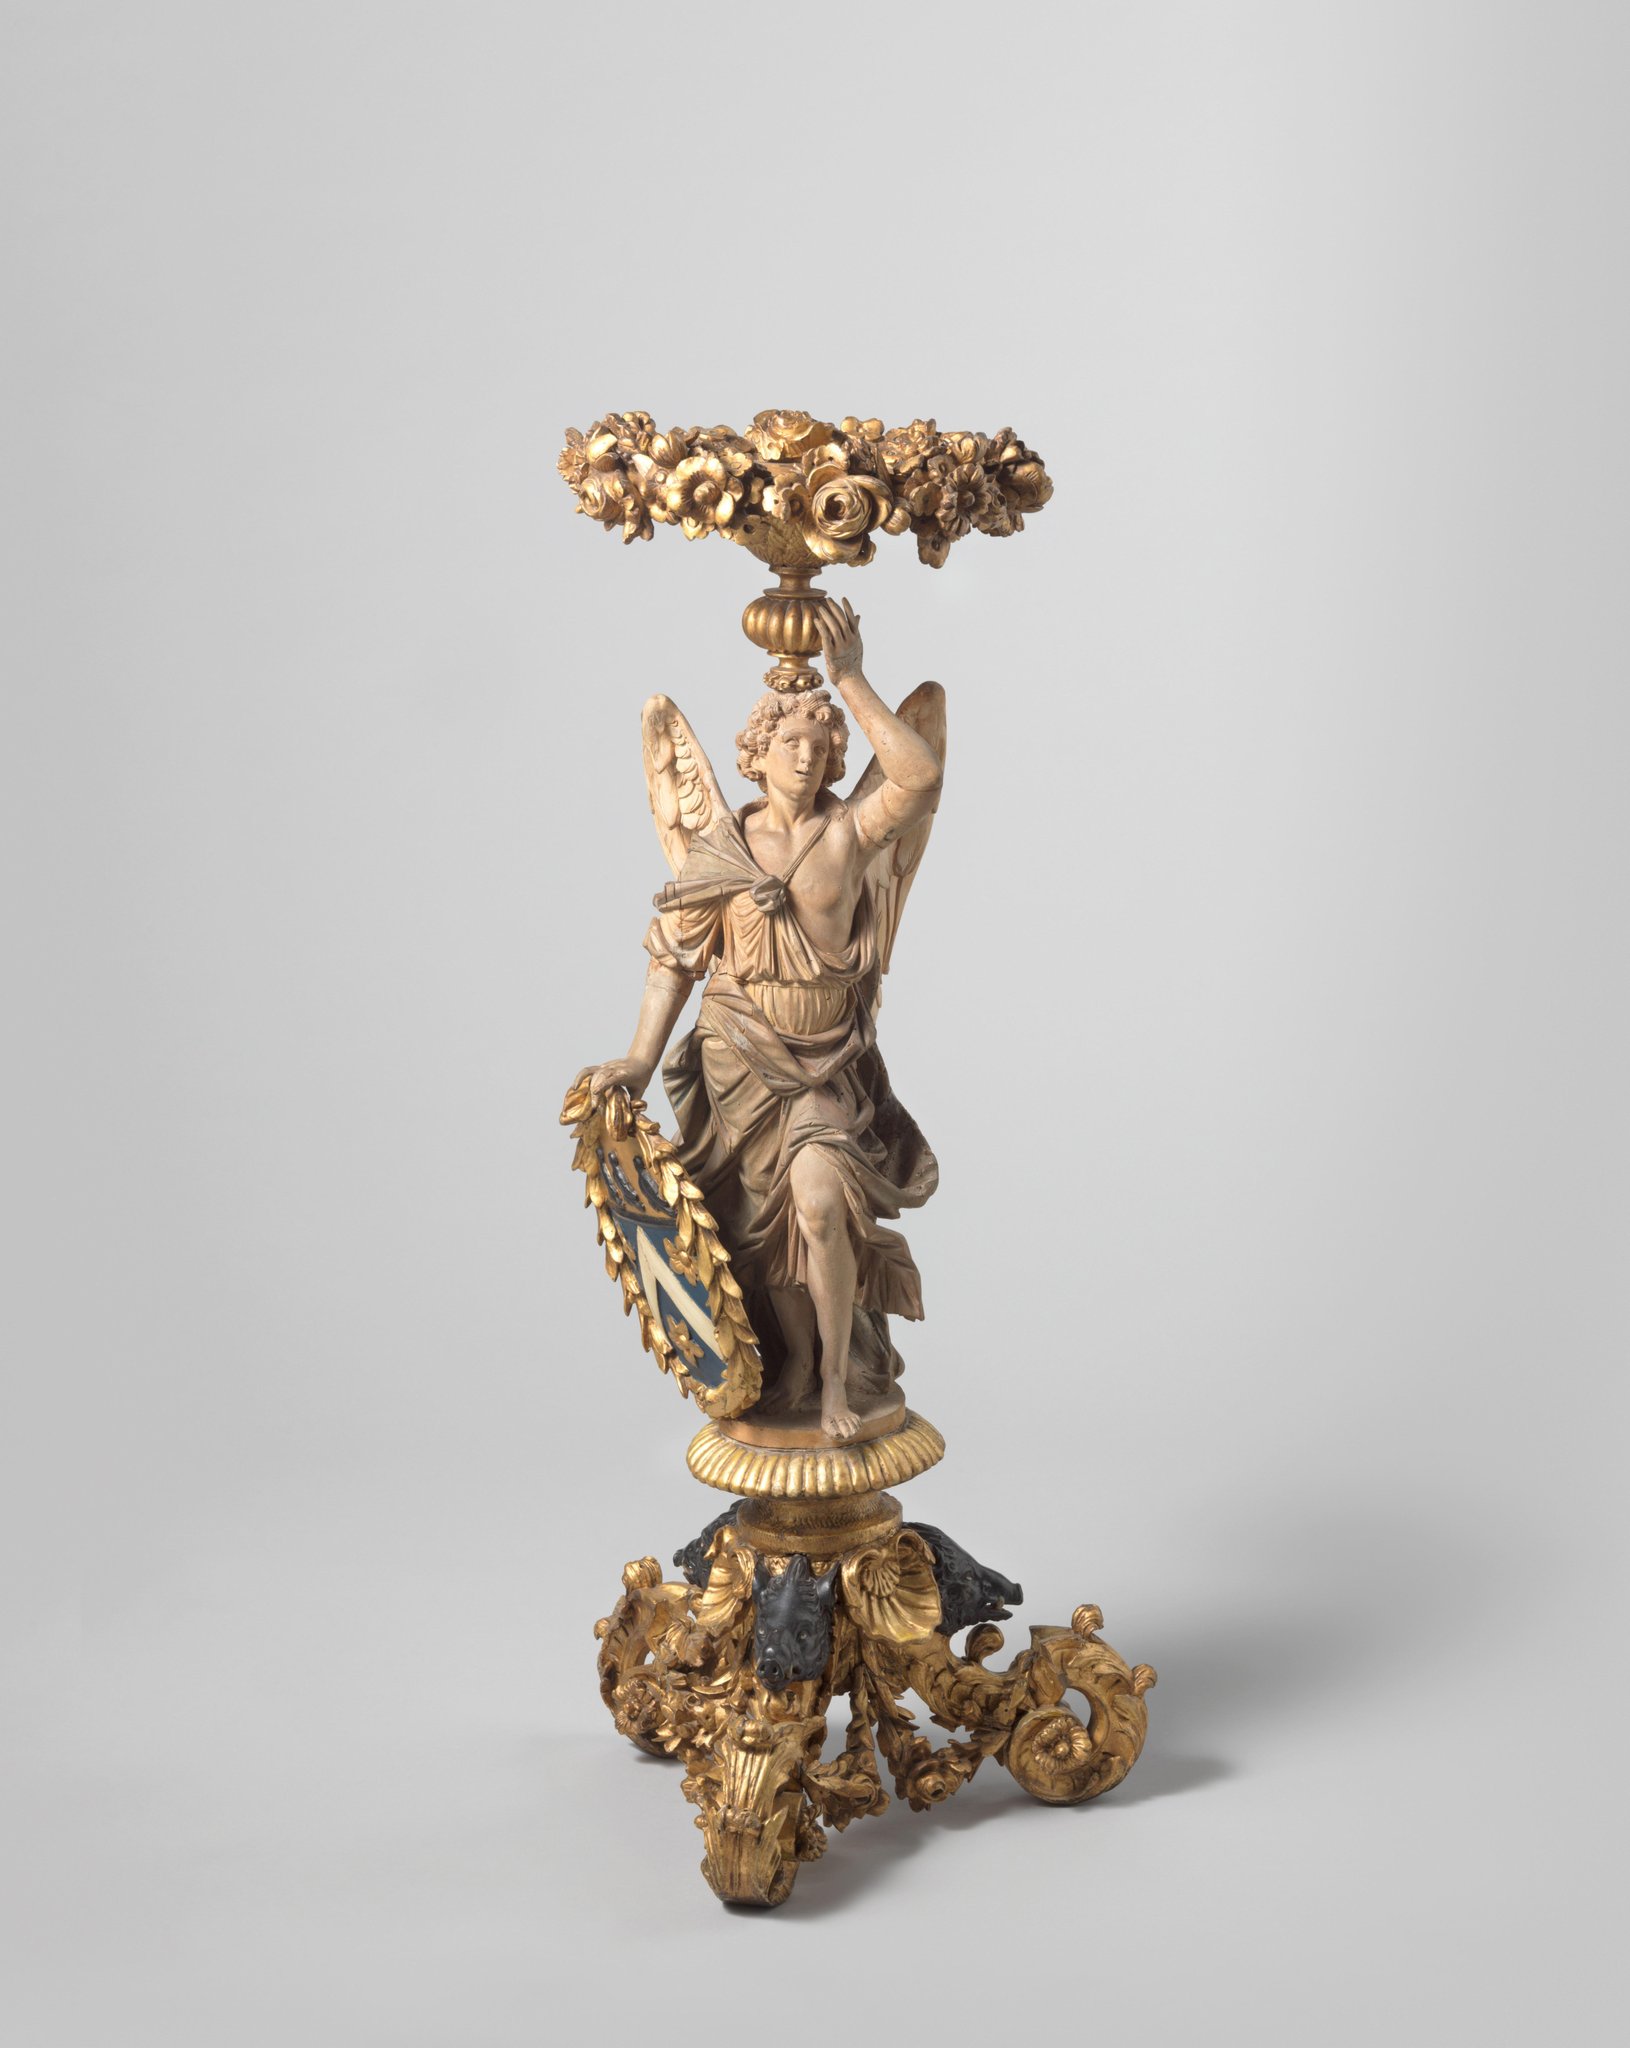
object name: furniture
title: Gueridon in de vorm van engelenfiguur in draperie waaronder voluutvormige driepoot met everzwijnkoppen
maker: Anonymous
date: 1700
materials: wood, paint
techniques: gilding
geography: netherlands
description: Gueridon van verguld gepolychromeerd lindehout op een voet met drie poten in de vorm van voluten, met acanthusblad en everzwijnkoppen versierd. Daarboven staat een engel in een gedrapeerd gewaad, die een schild vasthoudt en een boven het hoofd geplaatst rond blad, versierd met gestoken bladeren en bloemen. Wapen van Johan Boudaen (1634-1716). Afkomstig van het Huis Popkensburg in Zeeland. Opmerking: pendant BK-NM-3278